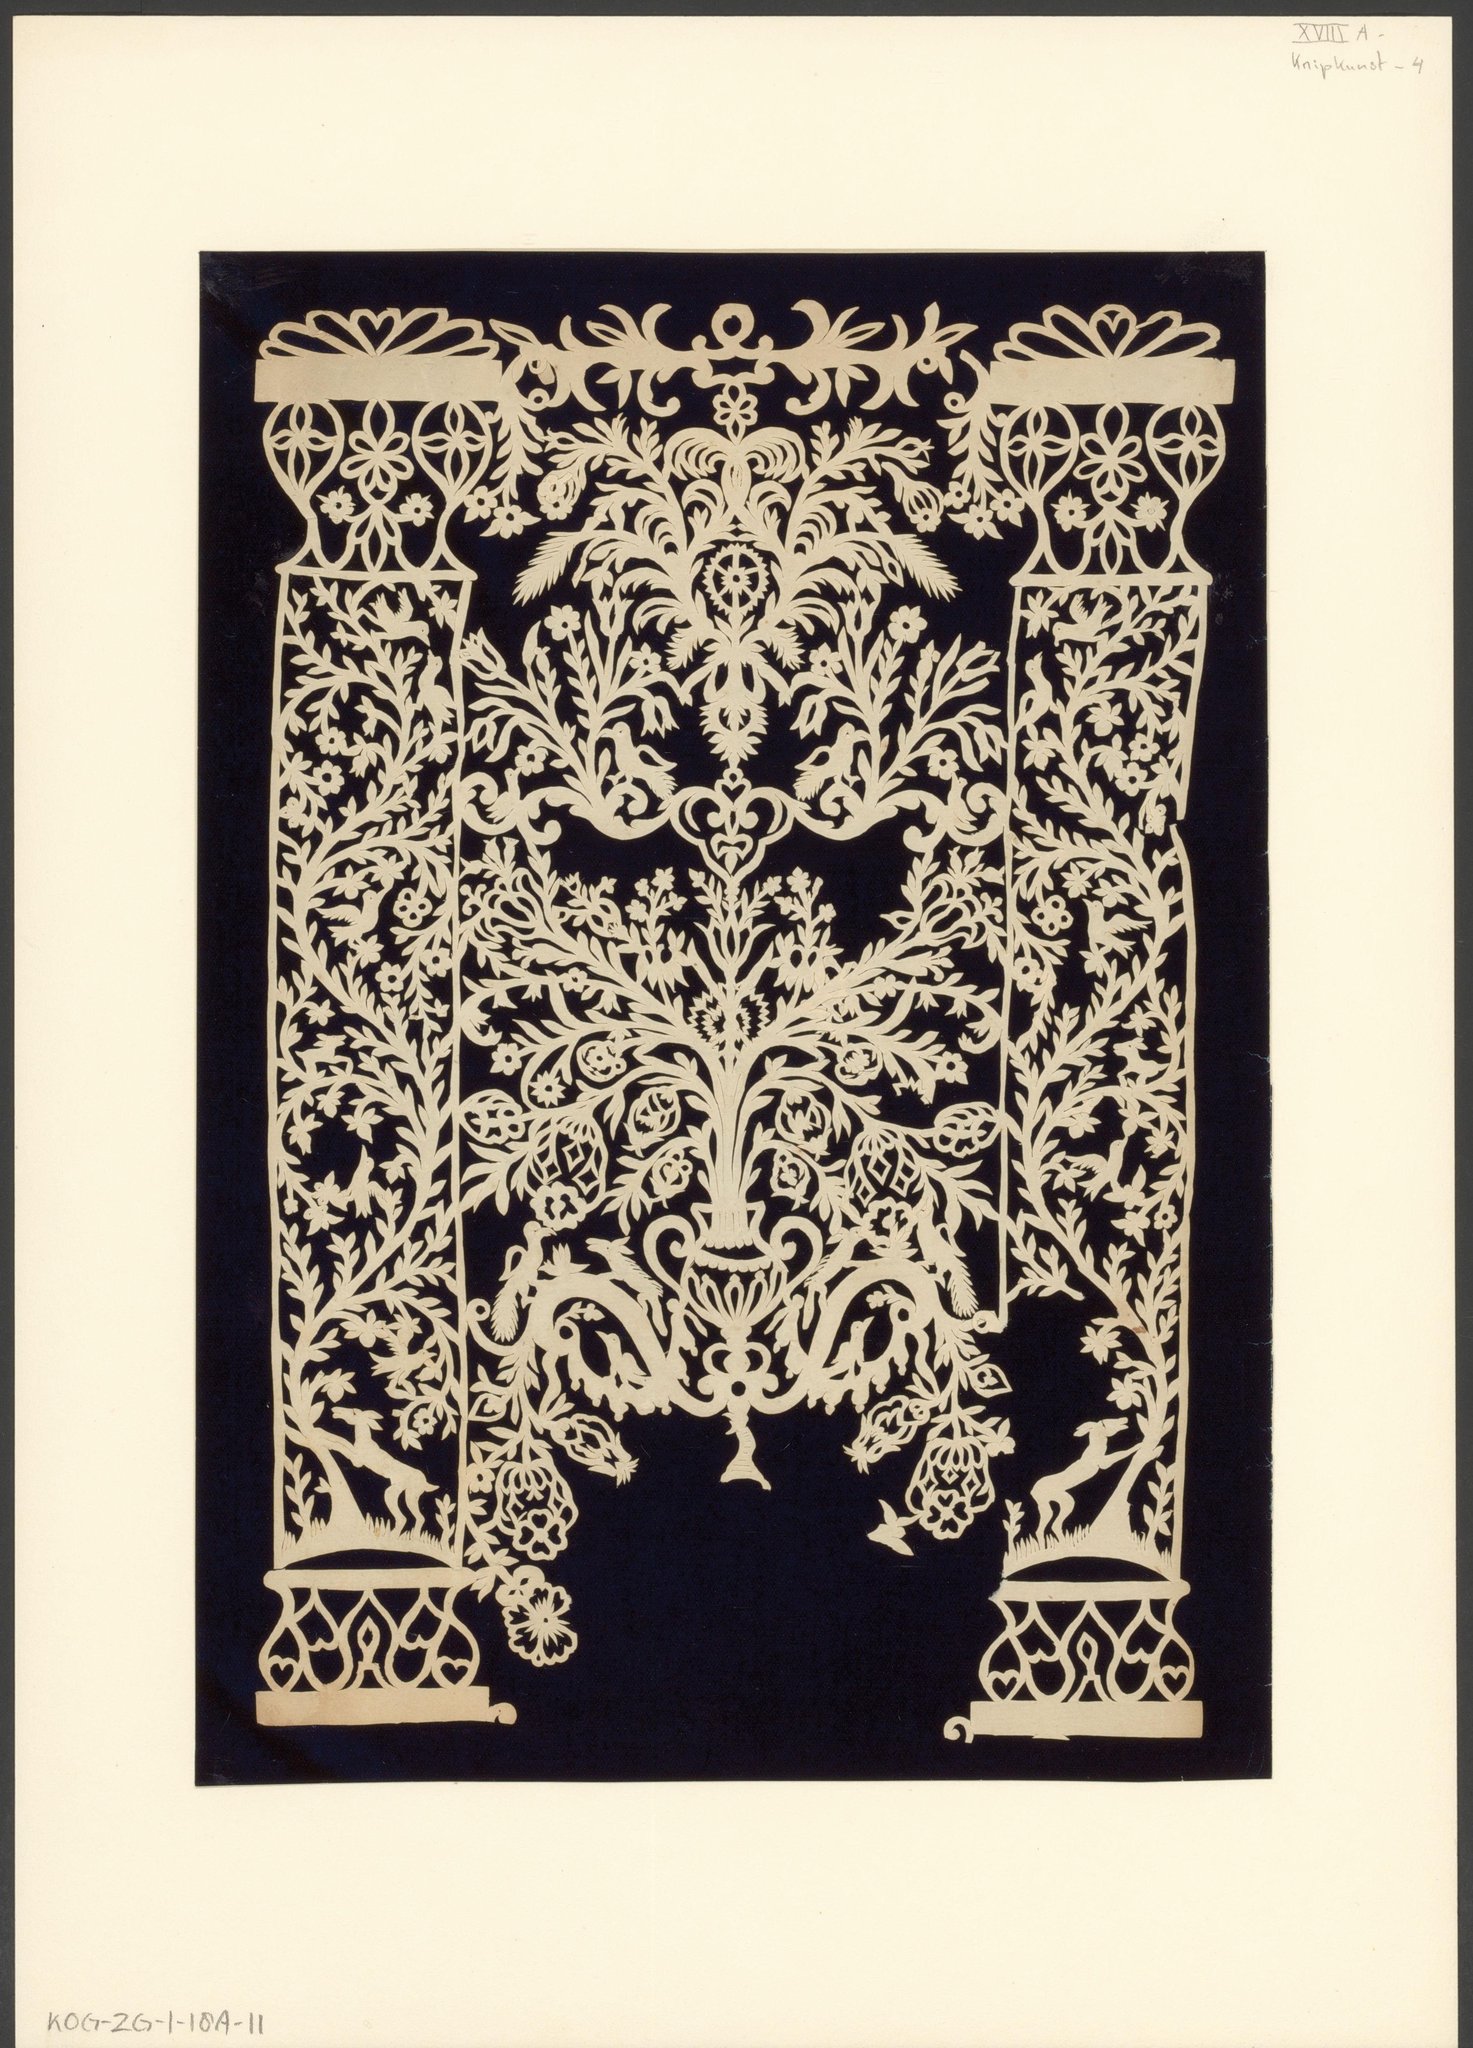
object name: cut paper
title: Huwelijksknipsel met twee zuilen met pot vol bloemen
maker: Anonymous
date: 1750-1849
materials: paper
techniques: cutting, snipping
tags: flowers, hoofed animals: deer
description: Twee zuilen met op iedere zuil bloemenranken, een klimmende dier en vogels. Tussen de zuilen een takken-en bloemendecoratie waartussen vogels en andere dieren met in top een klein rad in de vorm van een tandwiel. Onderwerpsrubrieken binnen de Atlas Zeden en Gewoonten: Schoone kunsten, Knipkunst.